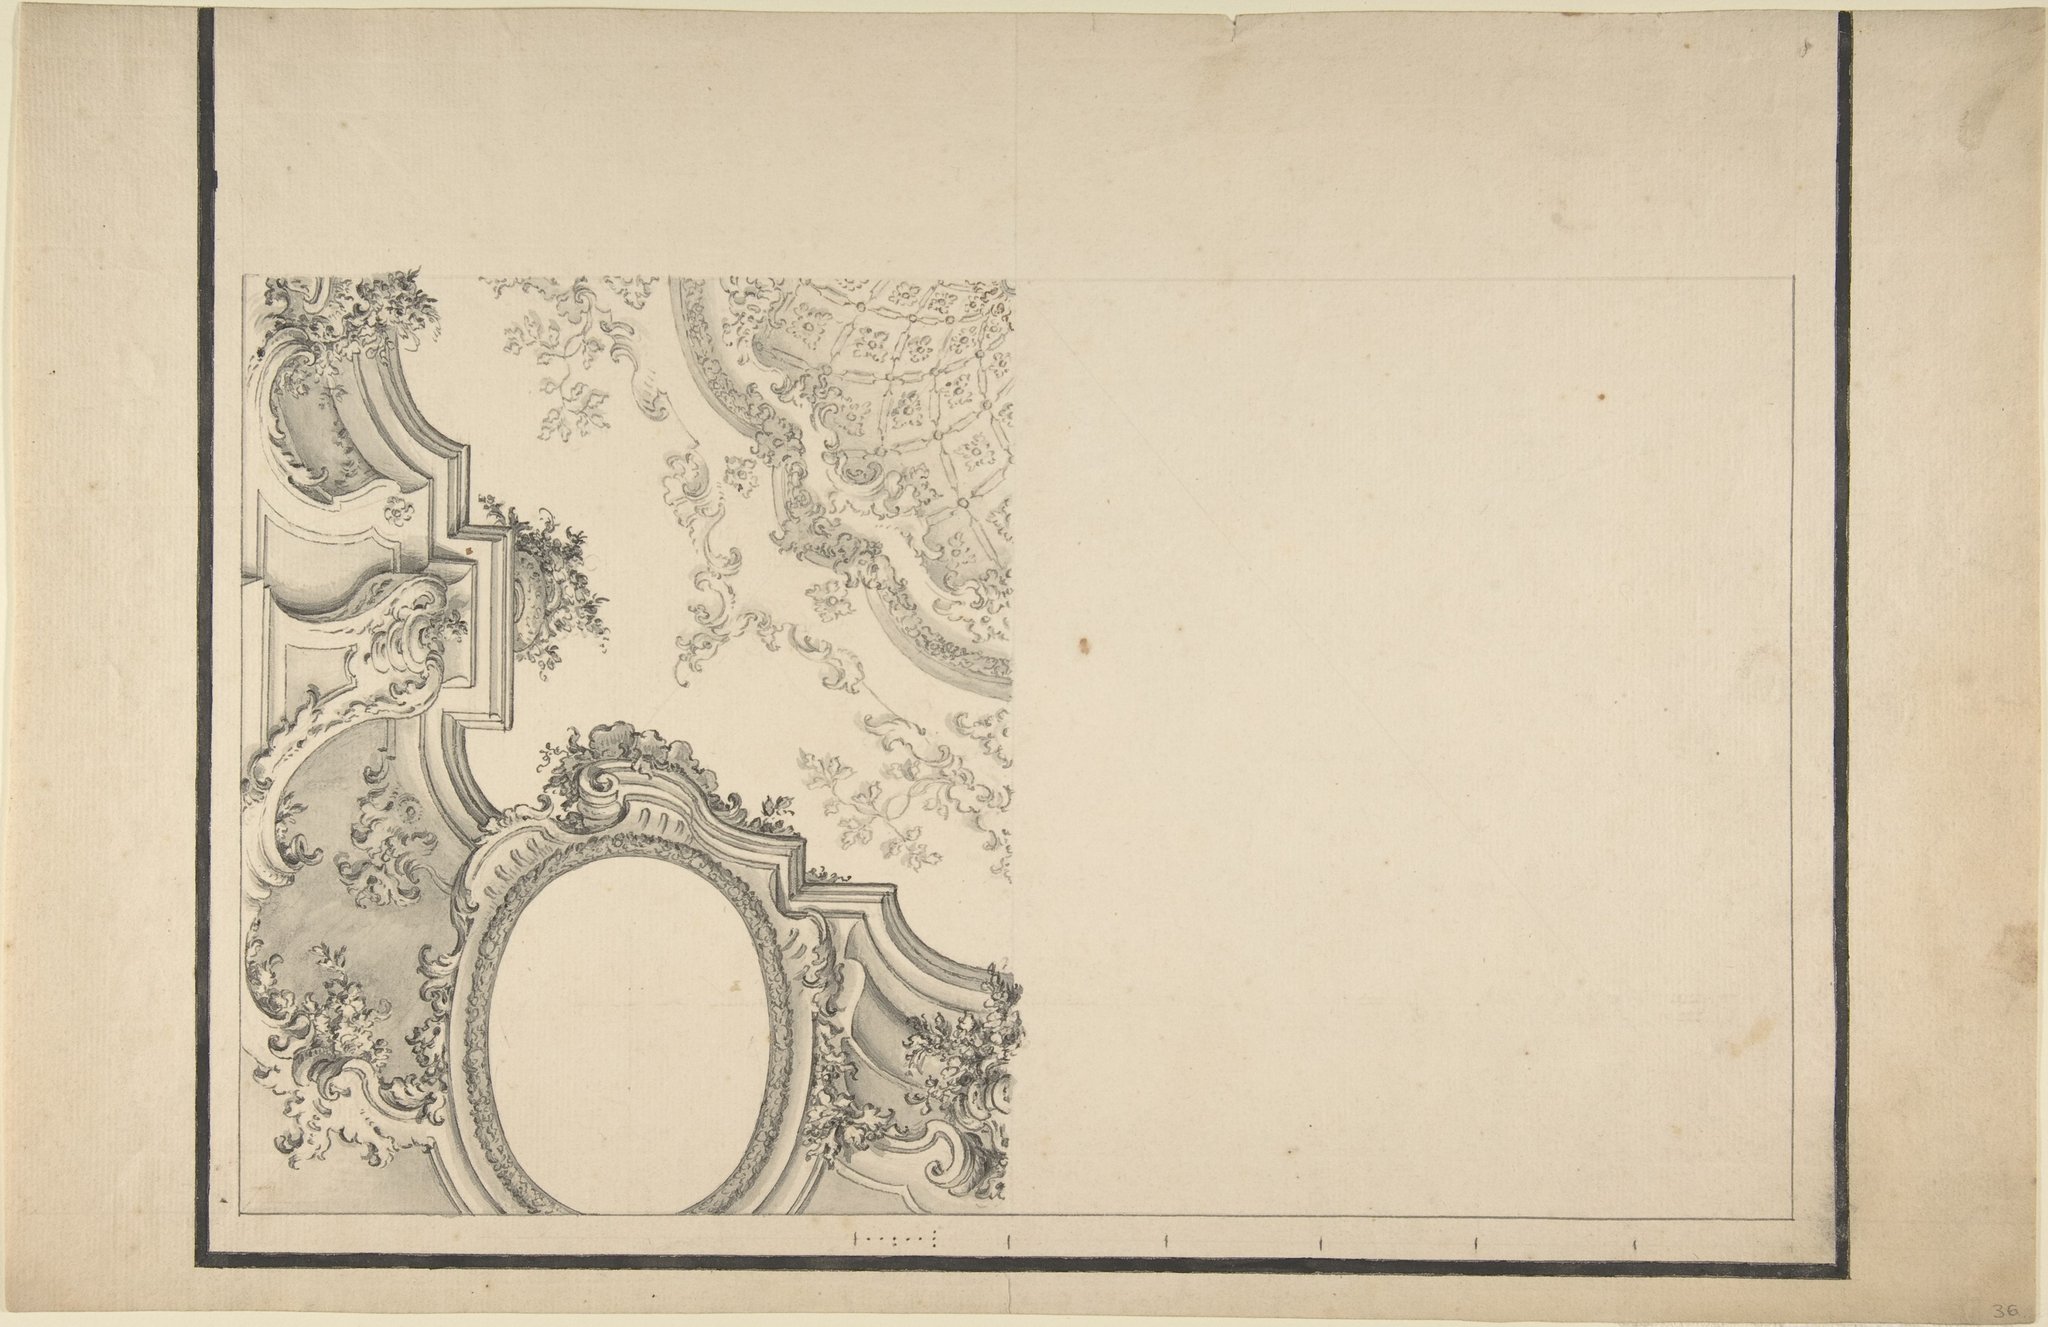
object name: drawing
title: Design for 1/4 of a Ceiling, and Ornamentation of a Section of a Vault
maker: anonymous, italian, piedmontese, 18th century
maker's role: artist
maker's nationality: italian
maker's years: 1700-1800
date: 1700-1780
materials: graphite, ink, drawing material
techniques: brush, pen, wash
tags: ornament